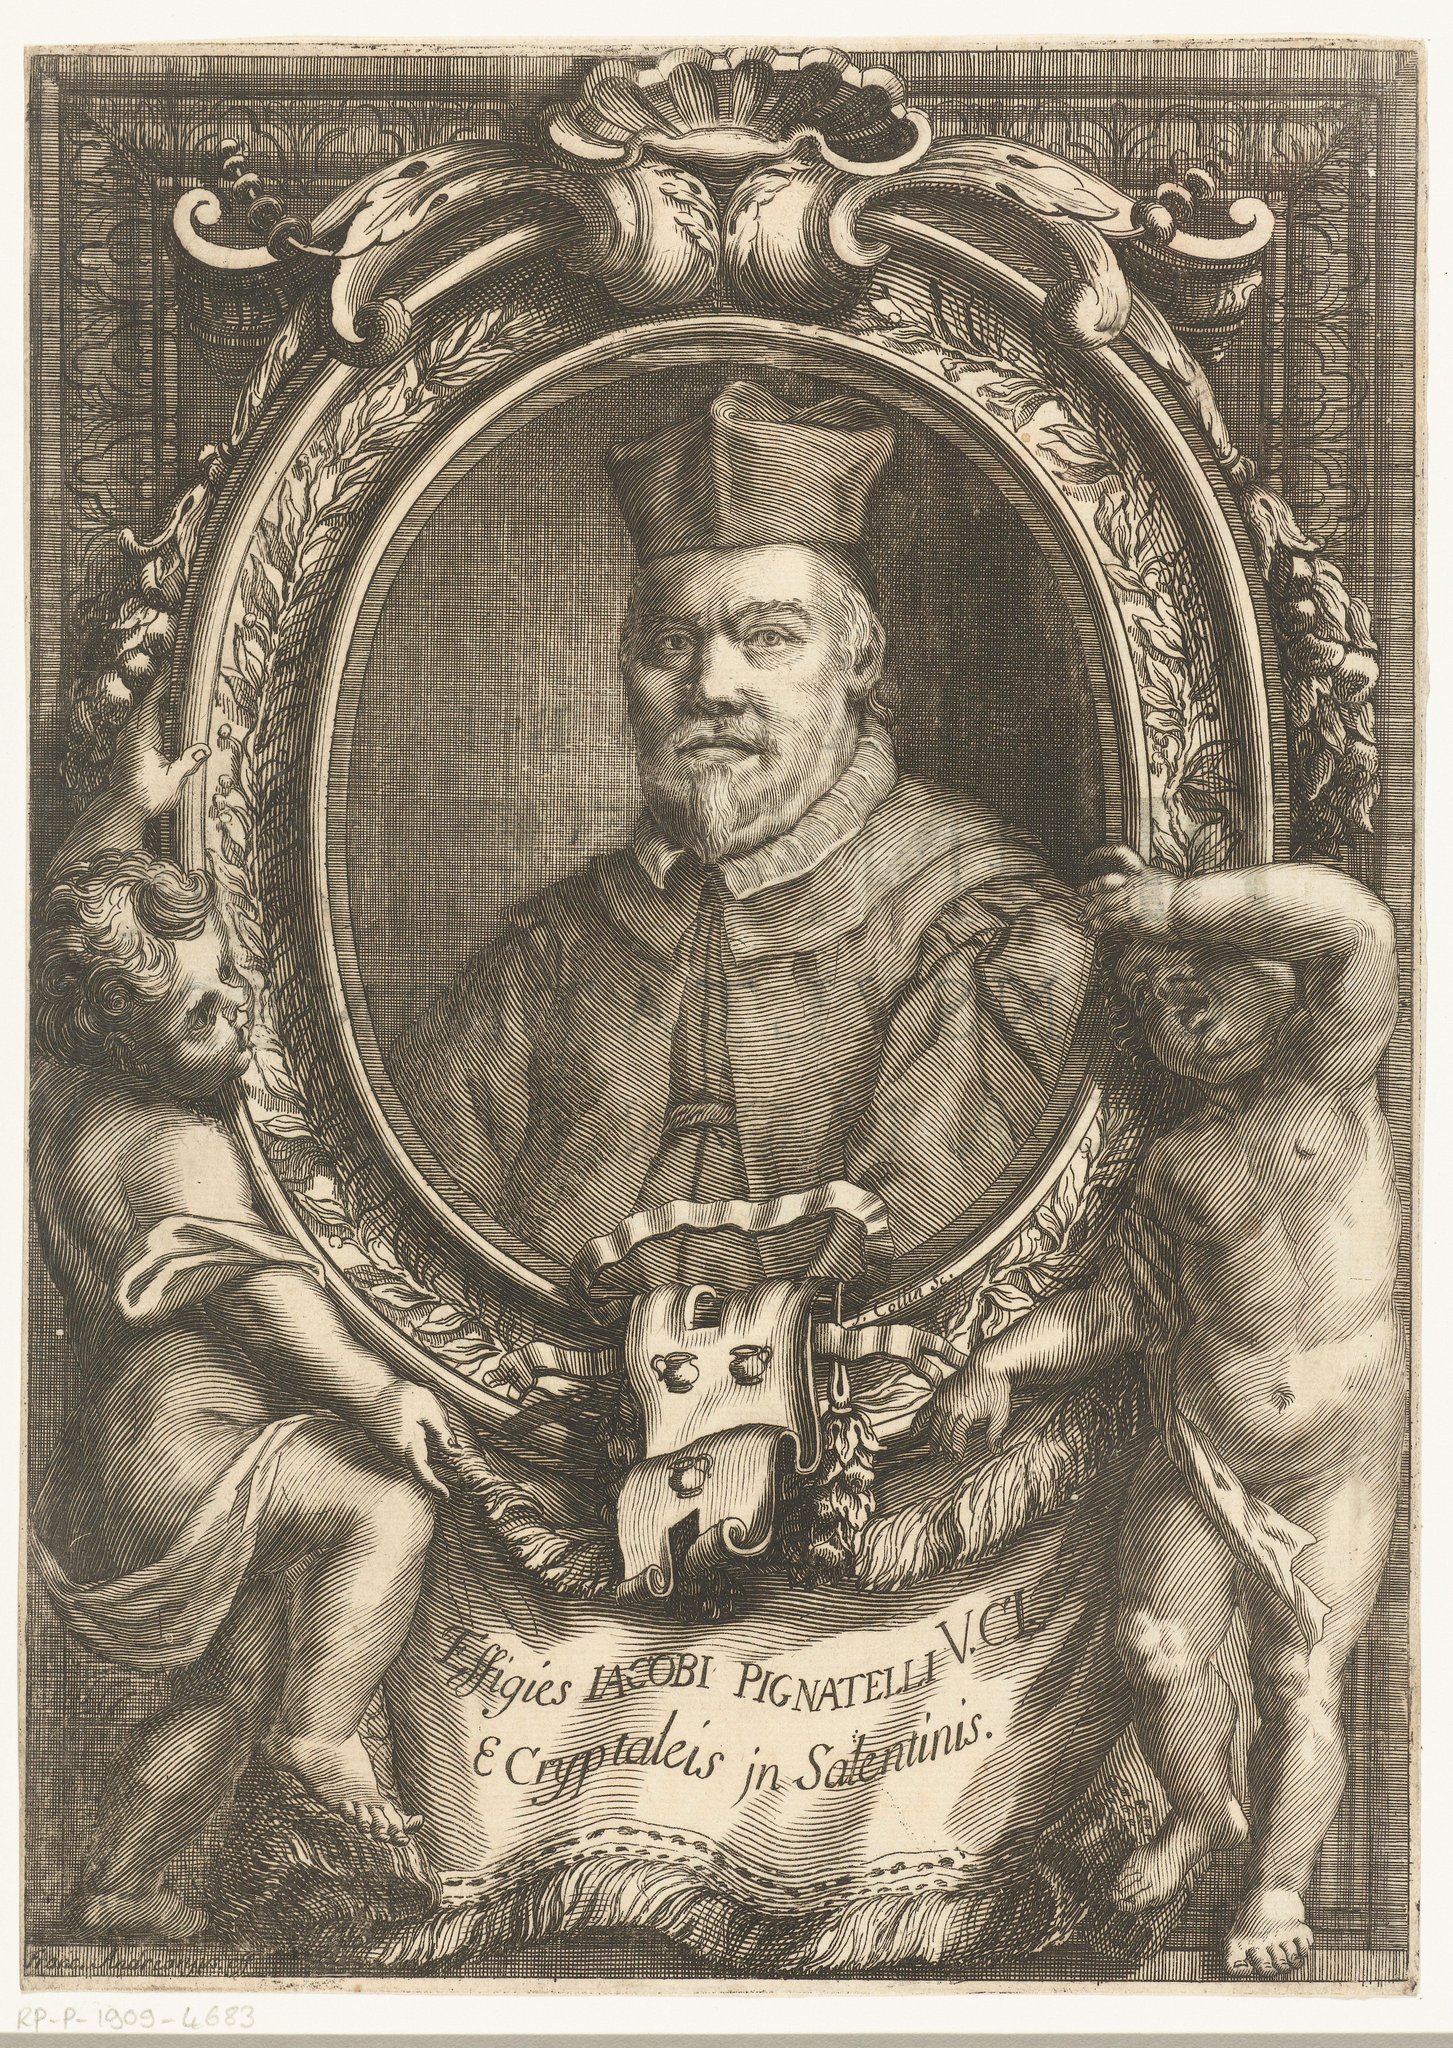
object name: book illustration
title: Portret van Jacob Pignatelli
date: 1675-1700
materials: paper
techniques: engraving, etching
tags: jurist, jacob pignatelli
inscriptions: collector's mark: Lugt 2228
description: Portret van de jurist Jacob Pignatelli in ovaal in een ornamentele lijst die wordt gehouden door twee putti. Onder aan de lijst een banderol met Pignatelli's familiewapen. Bladzijde uit een boek met tekst op het verso.